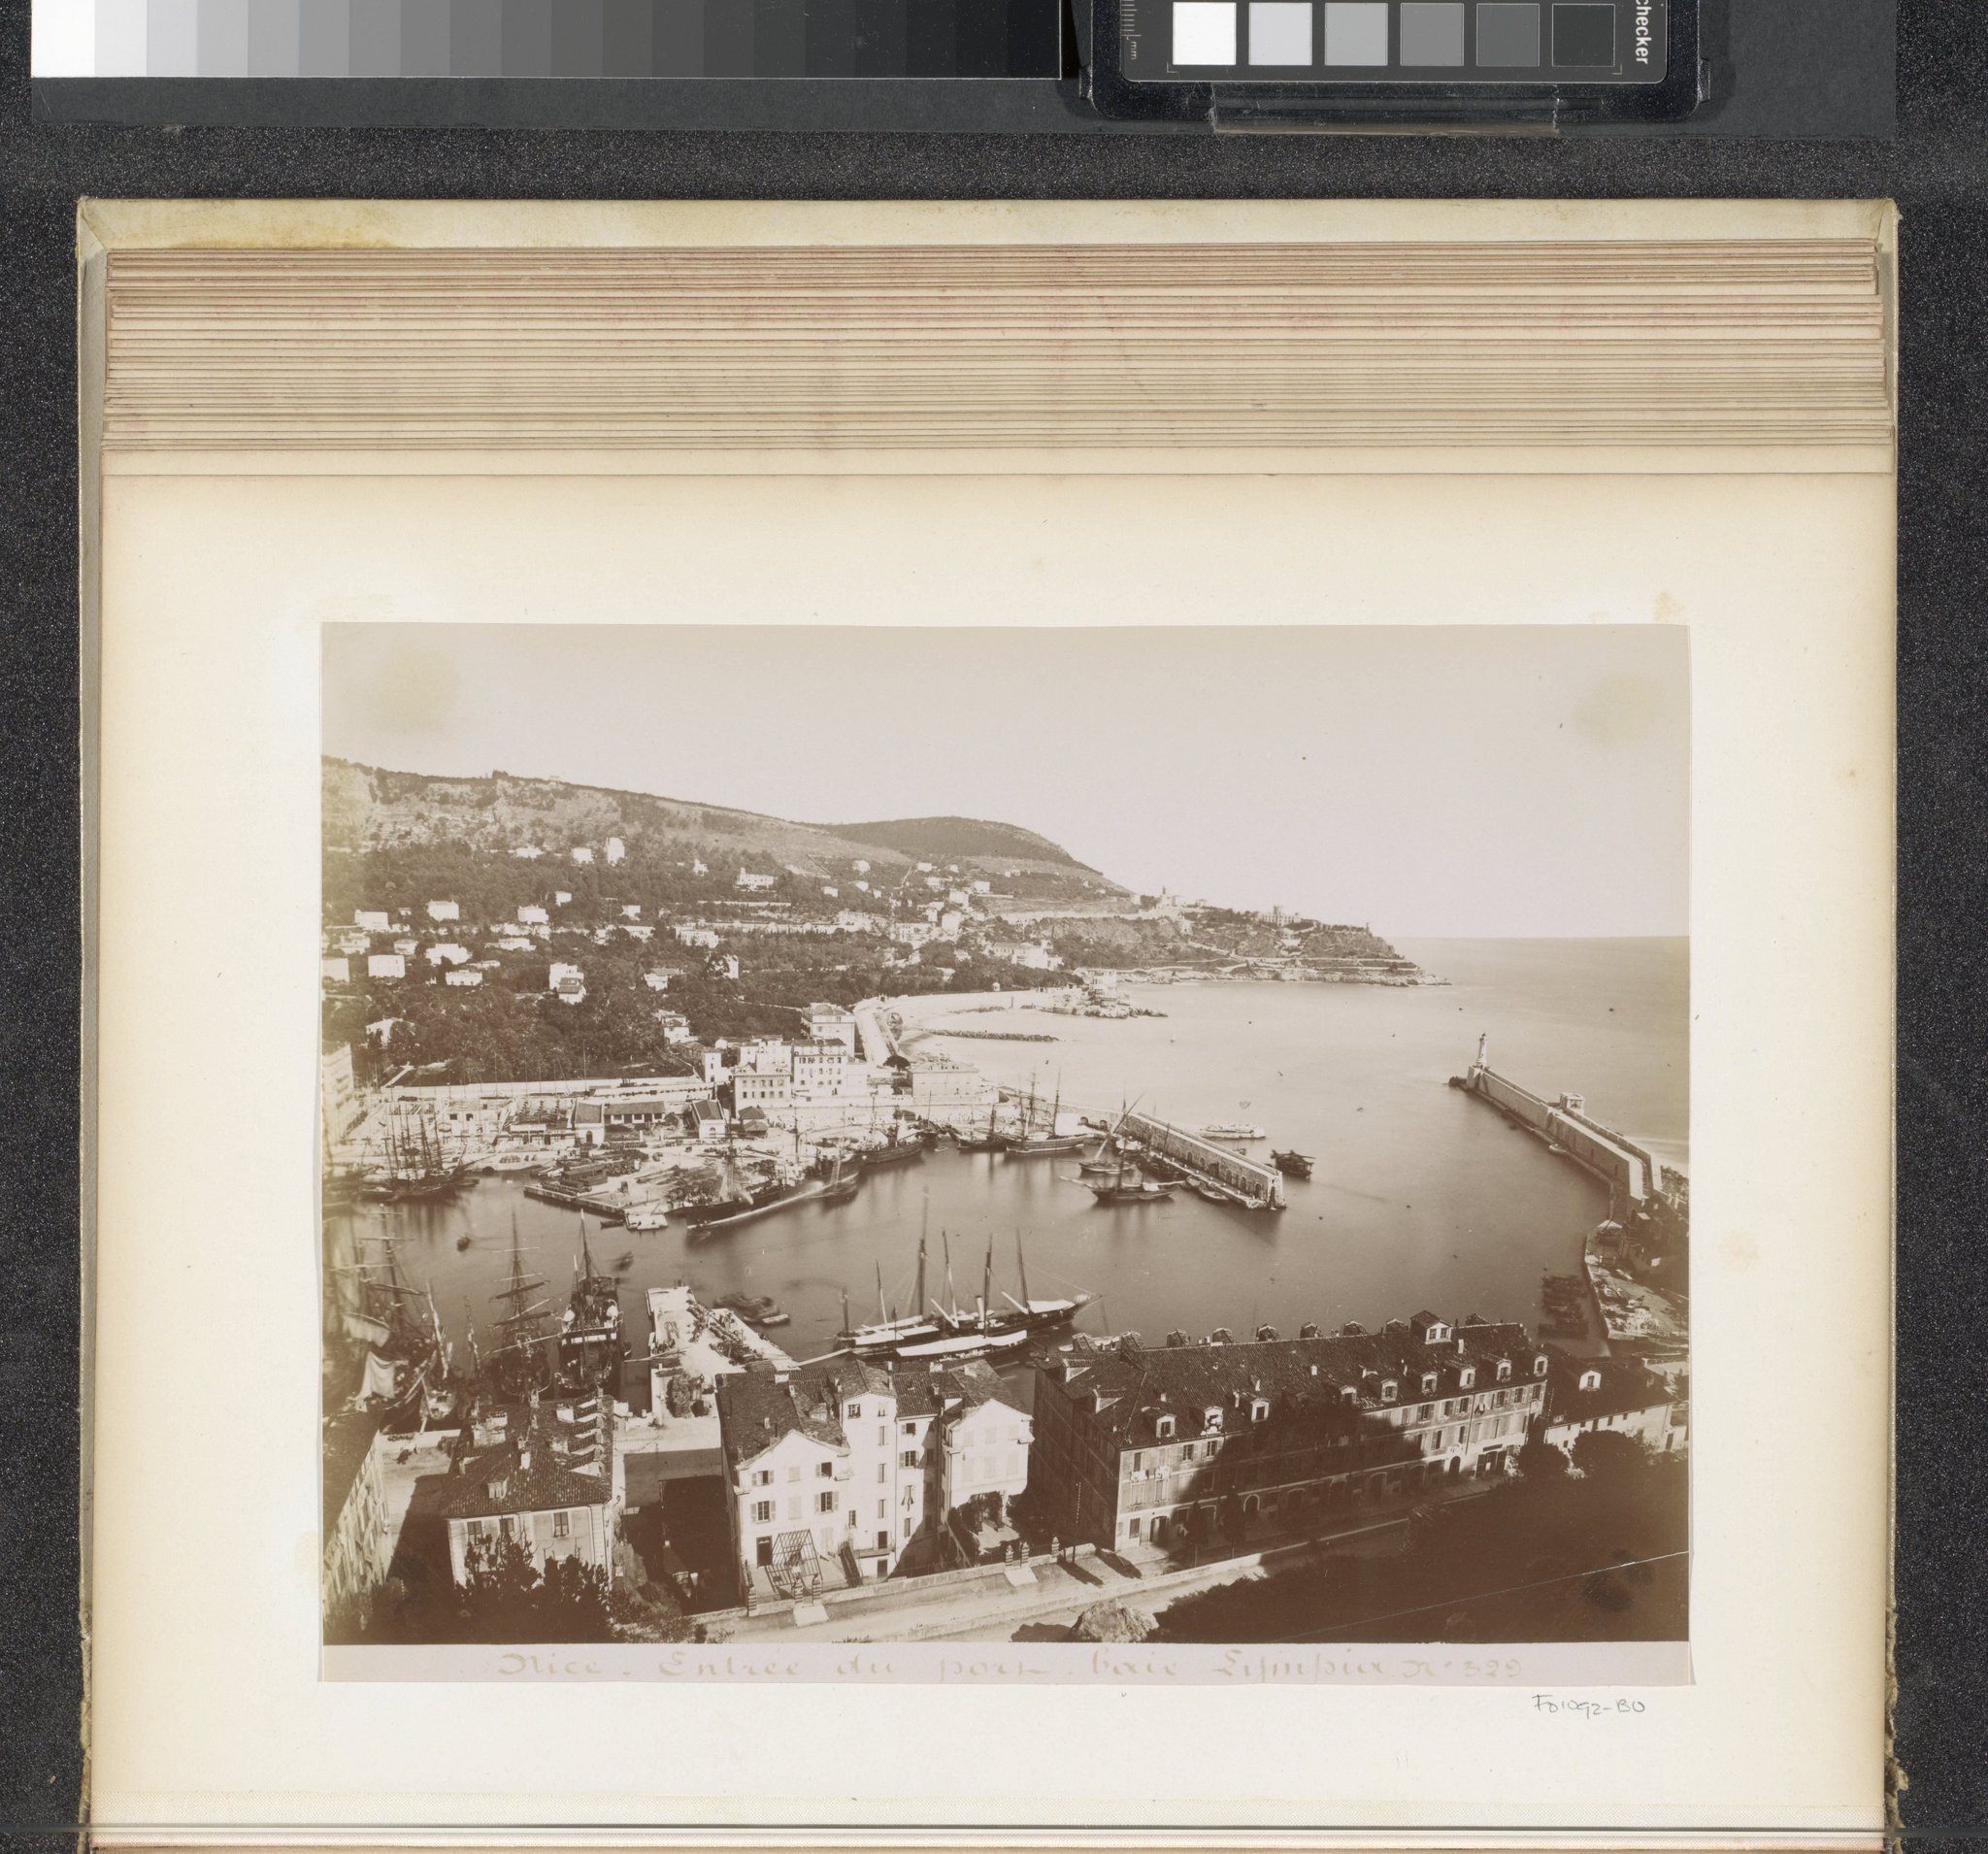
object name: photograph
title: Gezicht op de ingang van de haven van Nice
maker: Anonymous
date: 1883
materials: cardboard, paper, photographic support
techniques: albumen print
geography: nice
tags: harbour (+ view ~ vehicle, ship, etc.), prospect of city, town panorama, silhouette of city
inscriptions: negative number: ‘329’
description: Onderdeel van Reisalbum met foto's van bezienswaardigheden in België en Frankrijk.